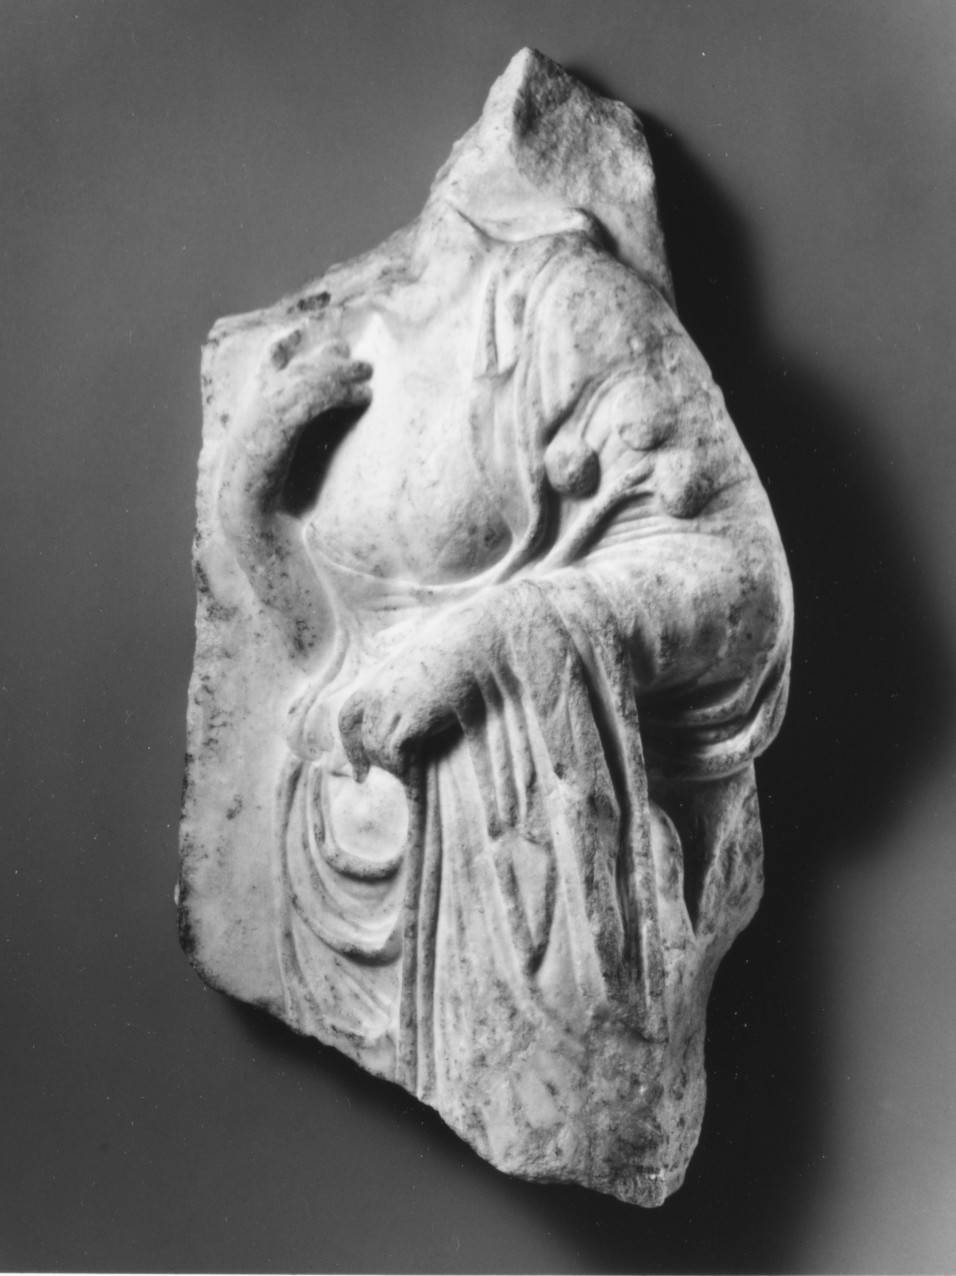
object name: relief fragment with torso of hesperid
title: Marble relief fragment with the torso of a Hesperid holding apples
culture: roman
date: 1-200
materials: marble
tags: human figures,apples